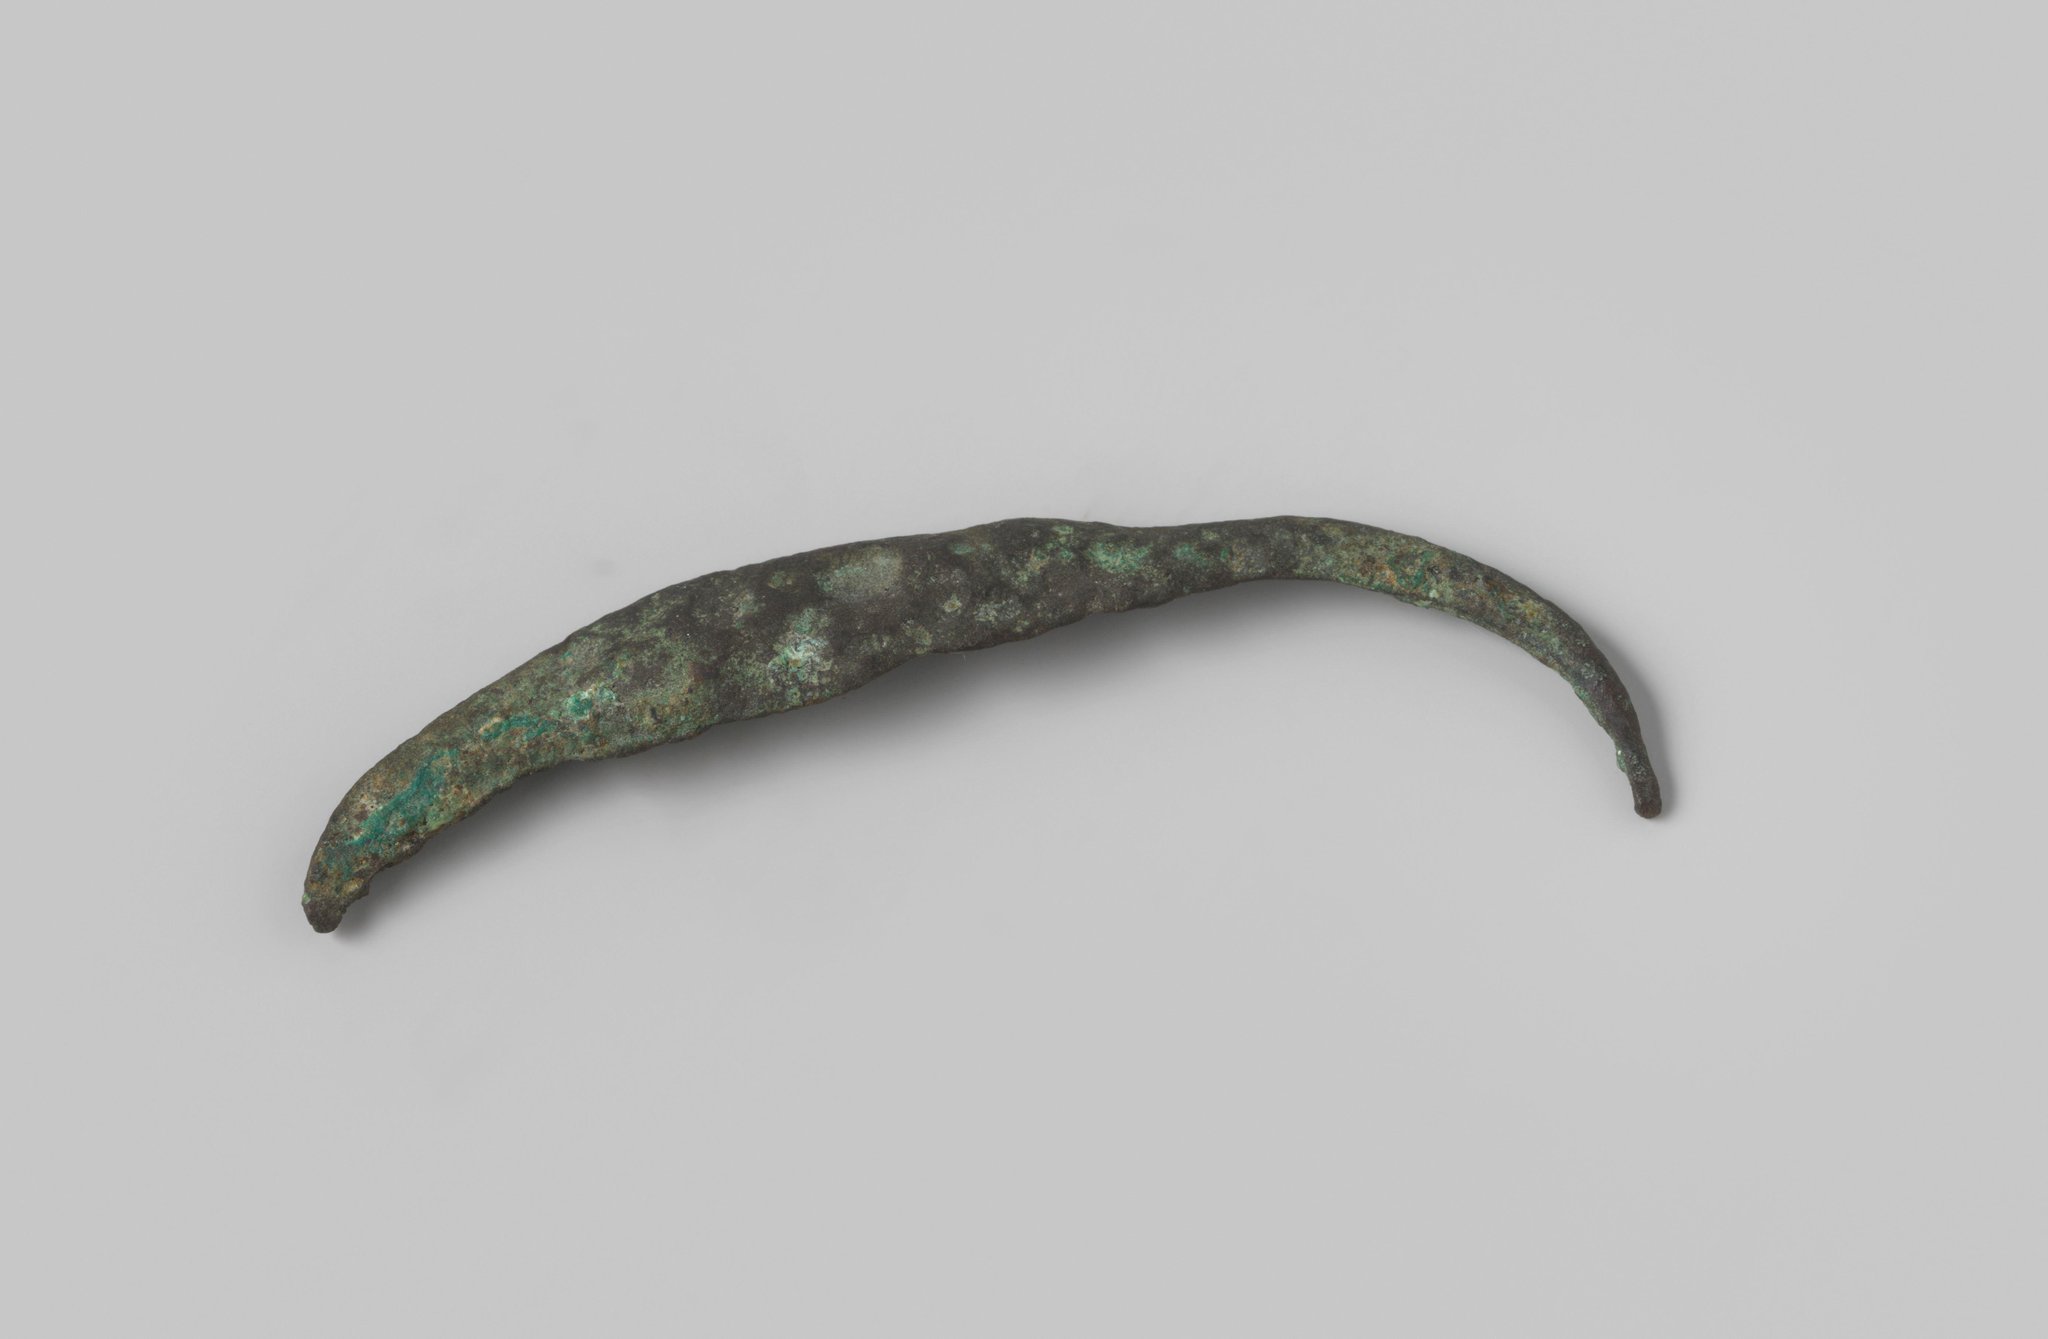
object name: beugel gevestl, gevestbeugel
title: Beugel van gevest uit het wrak van de Oost-Indiëvaarder Hollandia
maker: Anonymous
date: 1700-1743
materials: silver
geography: netherlands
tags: verenigde oostindische compagnie, hollandia (schip), annet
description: Hilt, guard; fragm of rim of shells, sim. NG 1980-27H3241, heavily corroded.